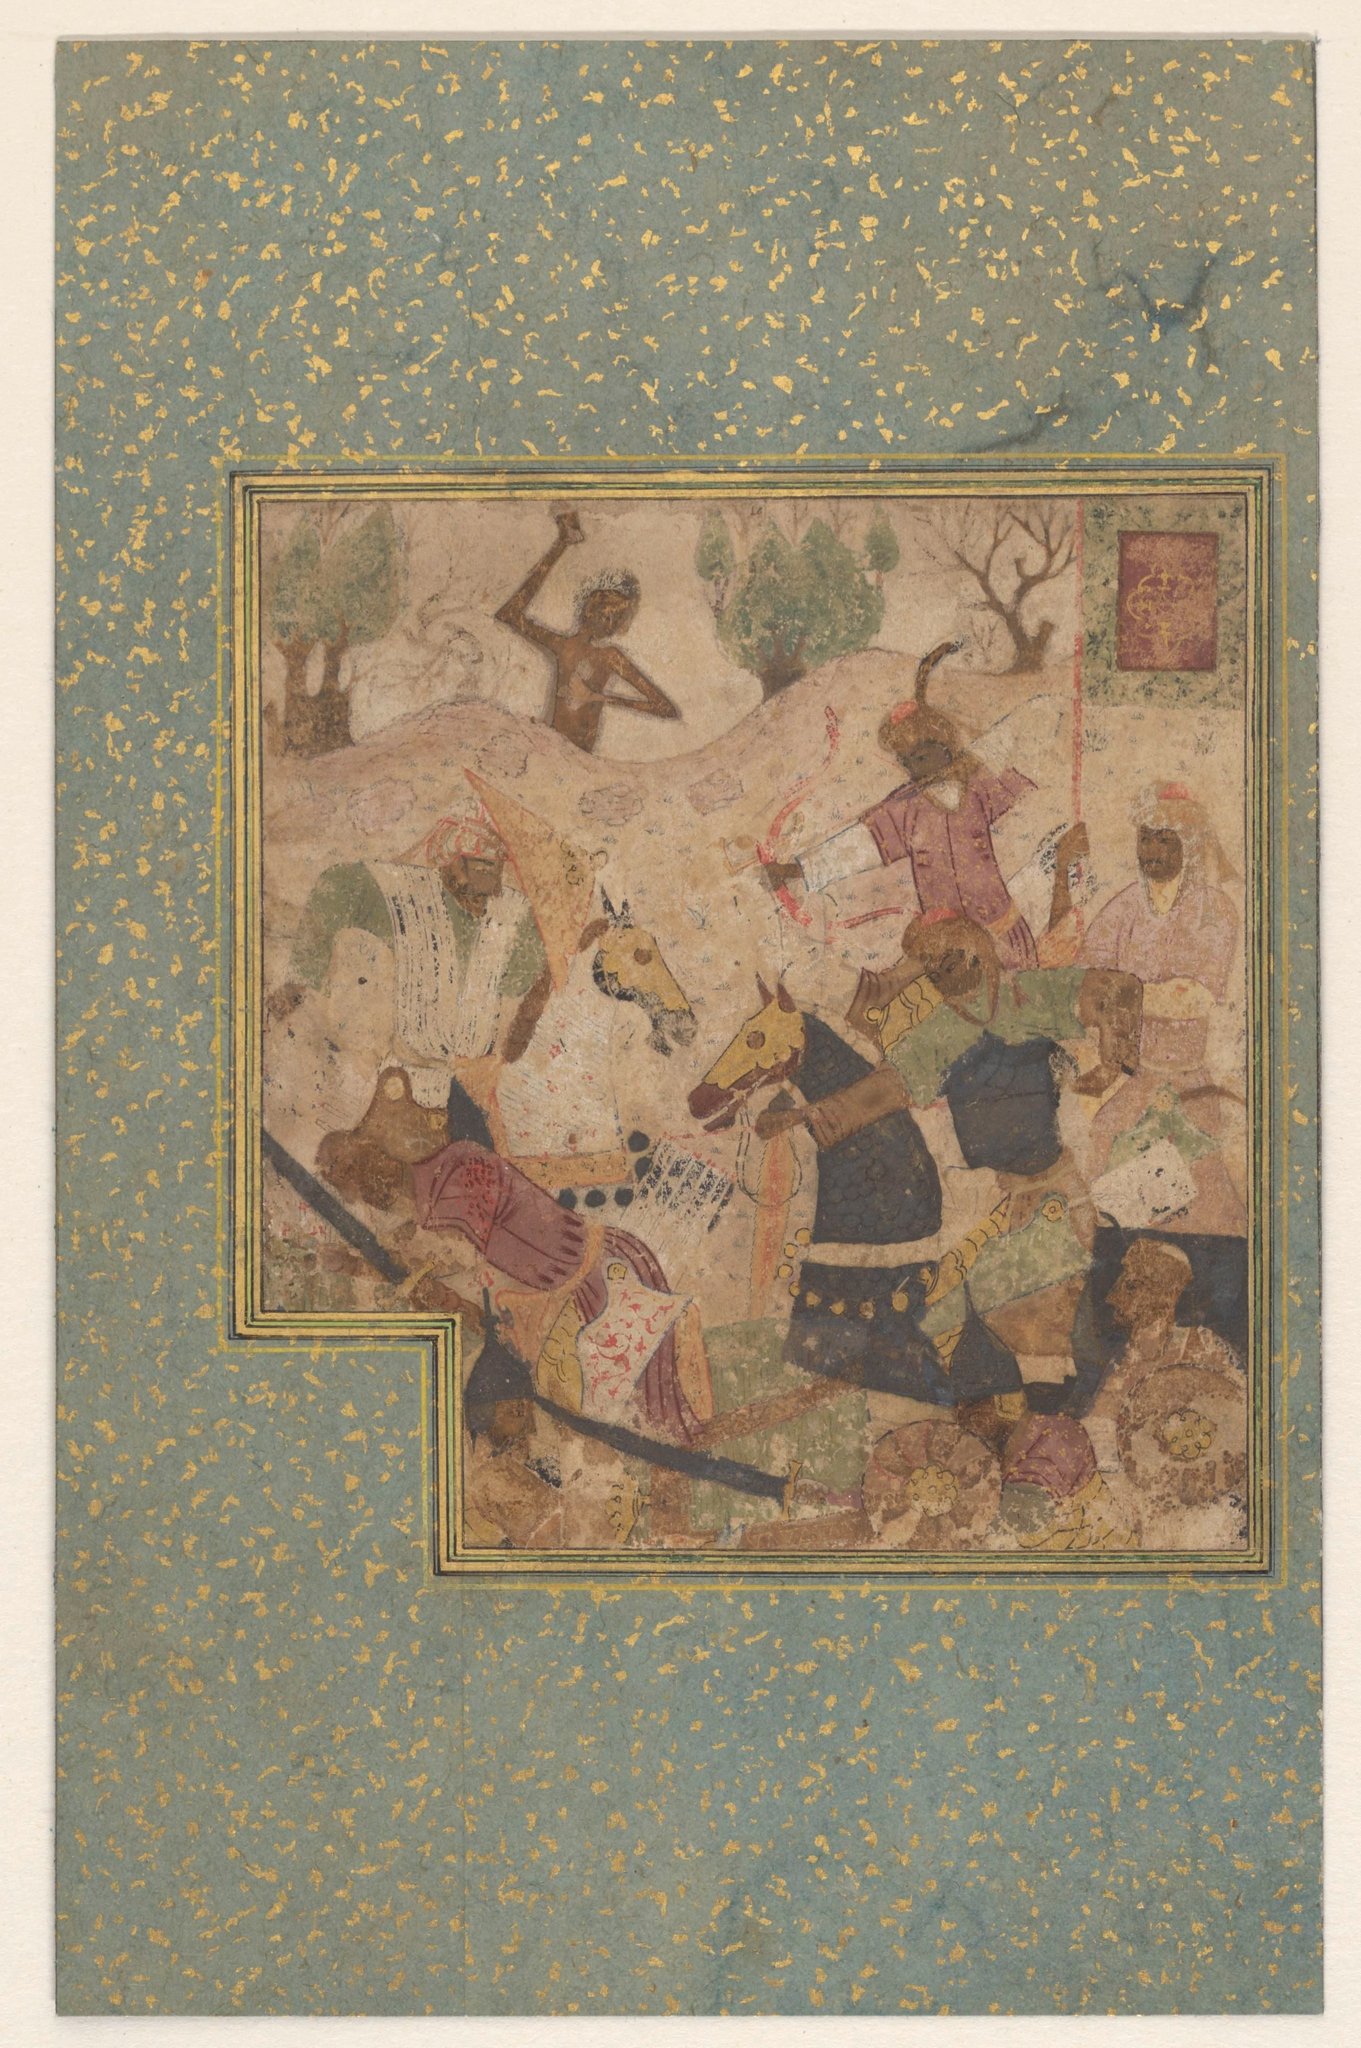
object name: persian miniature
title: Gevechtsscène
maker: Anonymous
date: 1450-1470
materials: paper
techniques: brush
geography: iran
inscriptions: inscription: ‘.’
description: Krijgsmannen te paard gaan elkaar te lijf met kruisbogen in een heuvelachtig landschap, aangemoedigd door een half ontblote figuur die veilig achter de heuveltoppen blijft. De voorstelling ligt op de rechterkant van een hemelsblauw met goud bespikkeld blad en is omlijst door goudkleurige kaderlijnen; in de hoek linksonder is een inham.